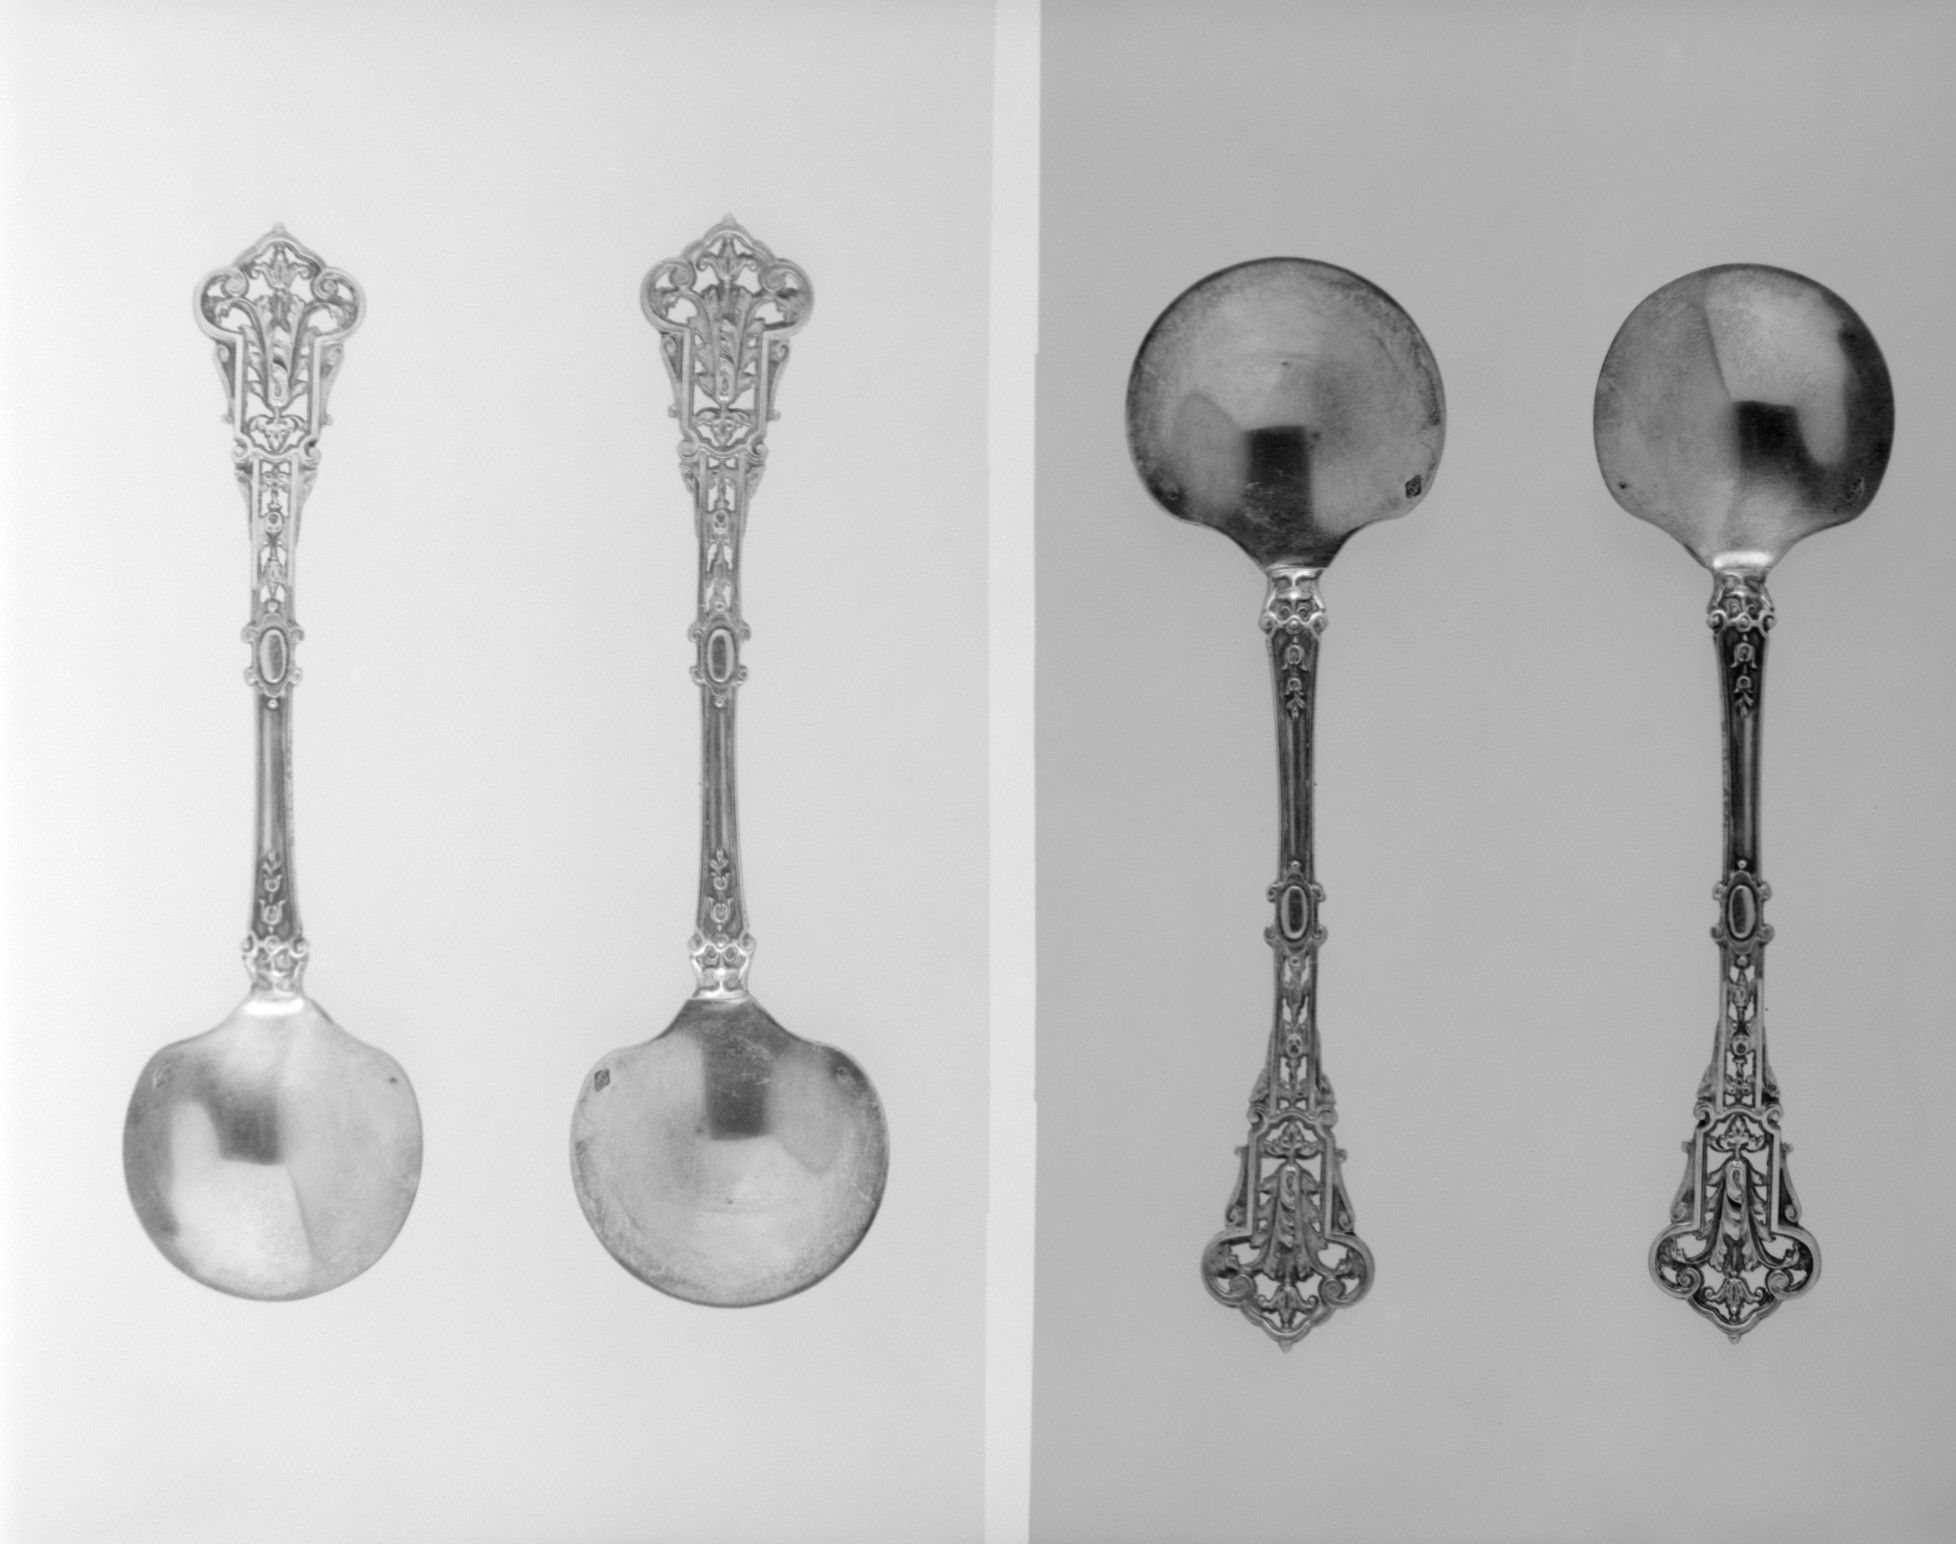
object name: ice cream spoon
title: Ice cream spoon (one of a pair)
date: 1801-1900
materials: silver